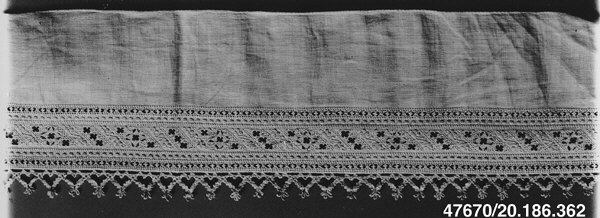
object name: swaddling band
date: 1501-1600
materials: linen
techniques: embroidery